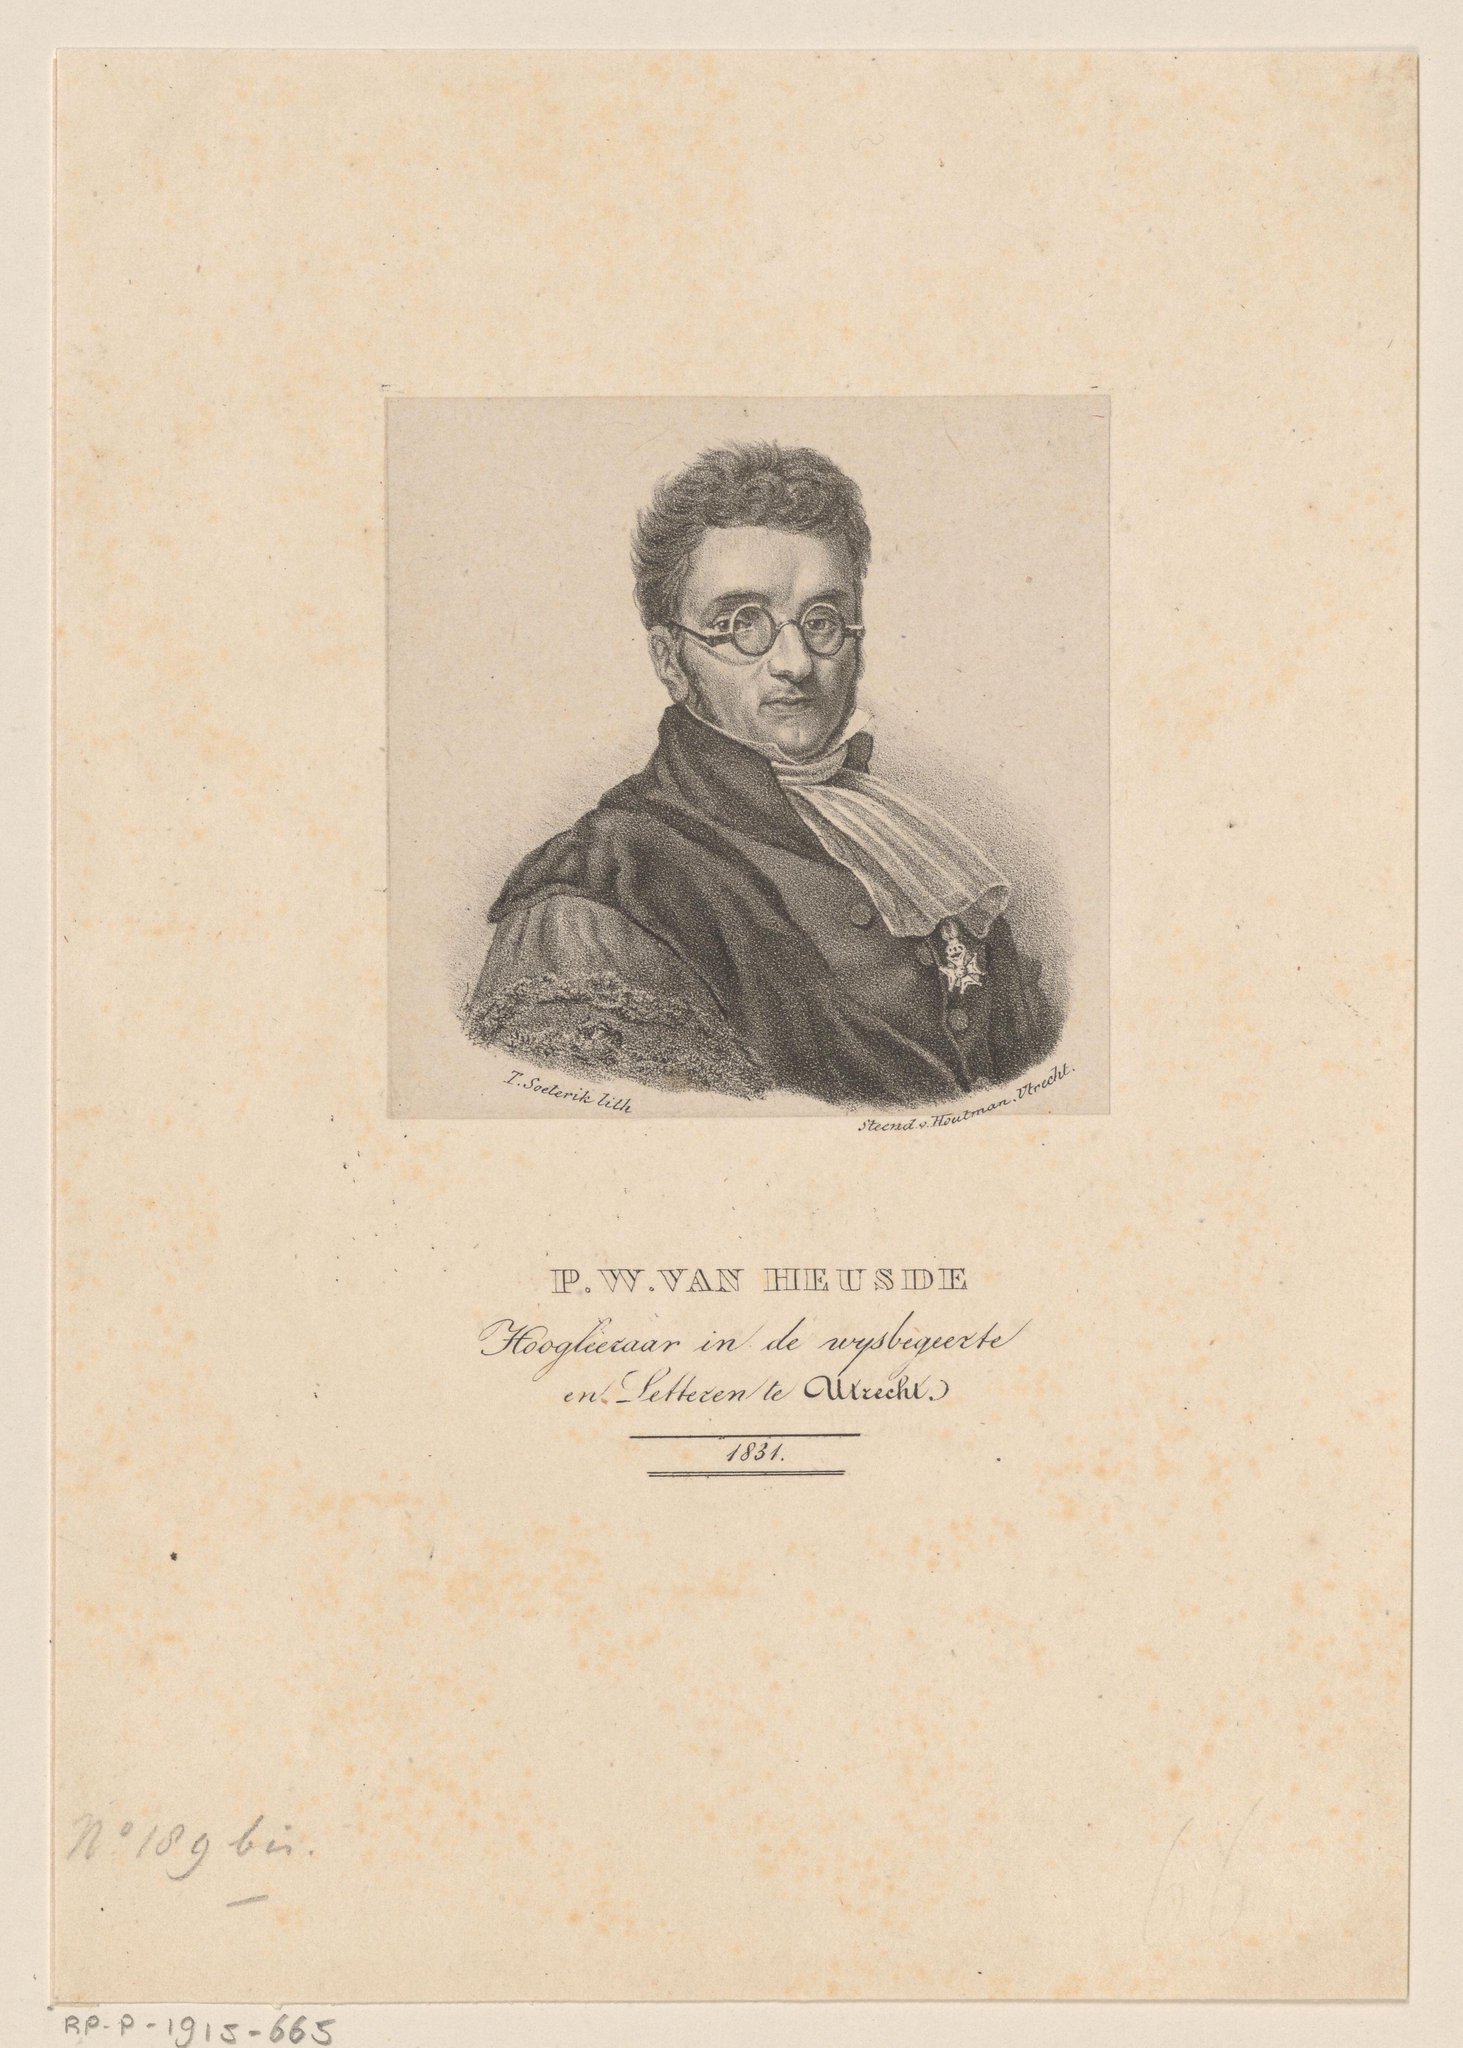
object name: print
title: Portret van Philip Willem van Heusde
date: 1831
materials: paper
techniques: lithograph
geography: utrecht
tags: eyeglasses, spectacles, scholar, philosopher, historical persons, professor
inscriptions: collector's mark: Lugt 2228